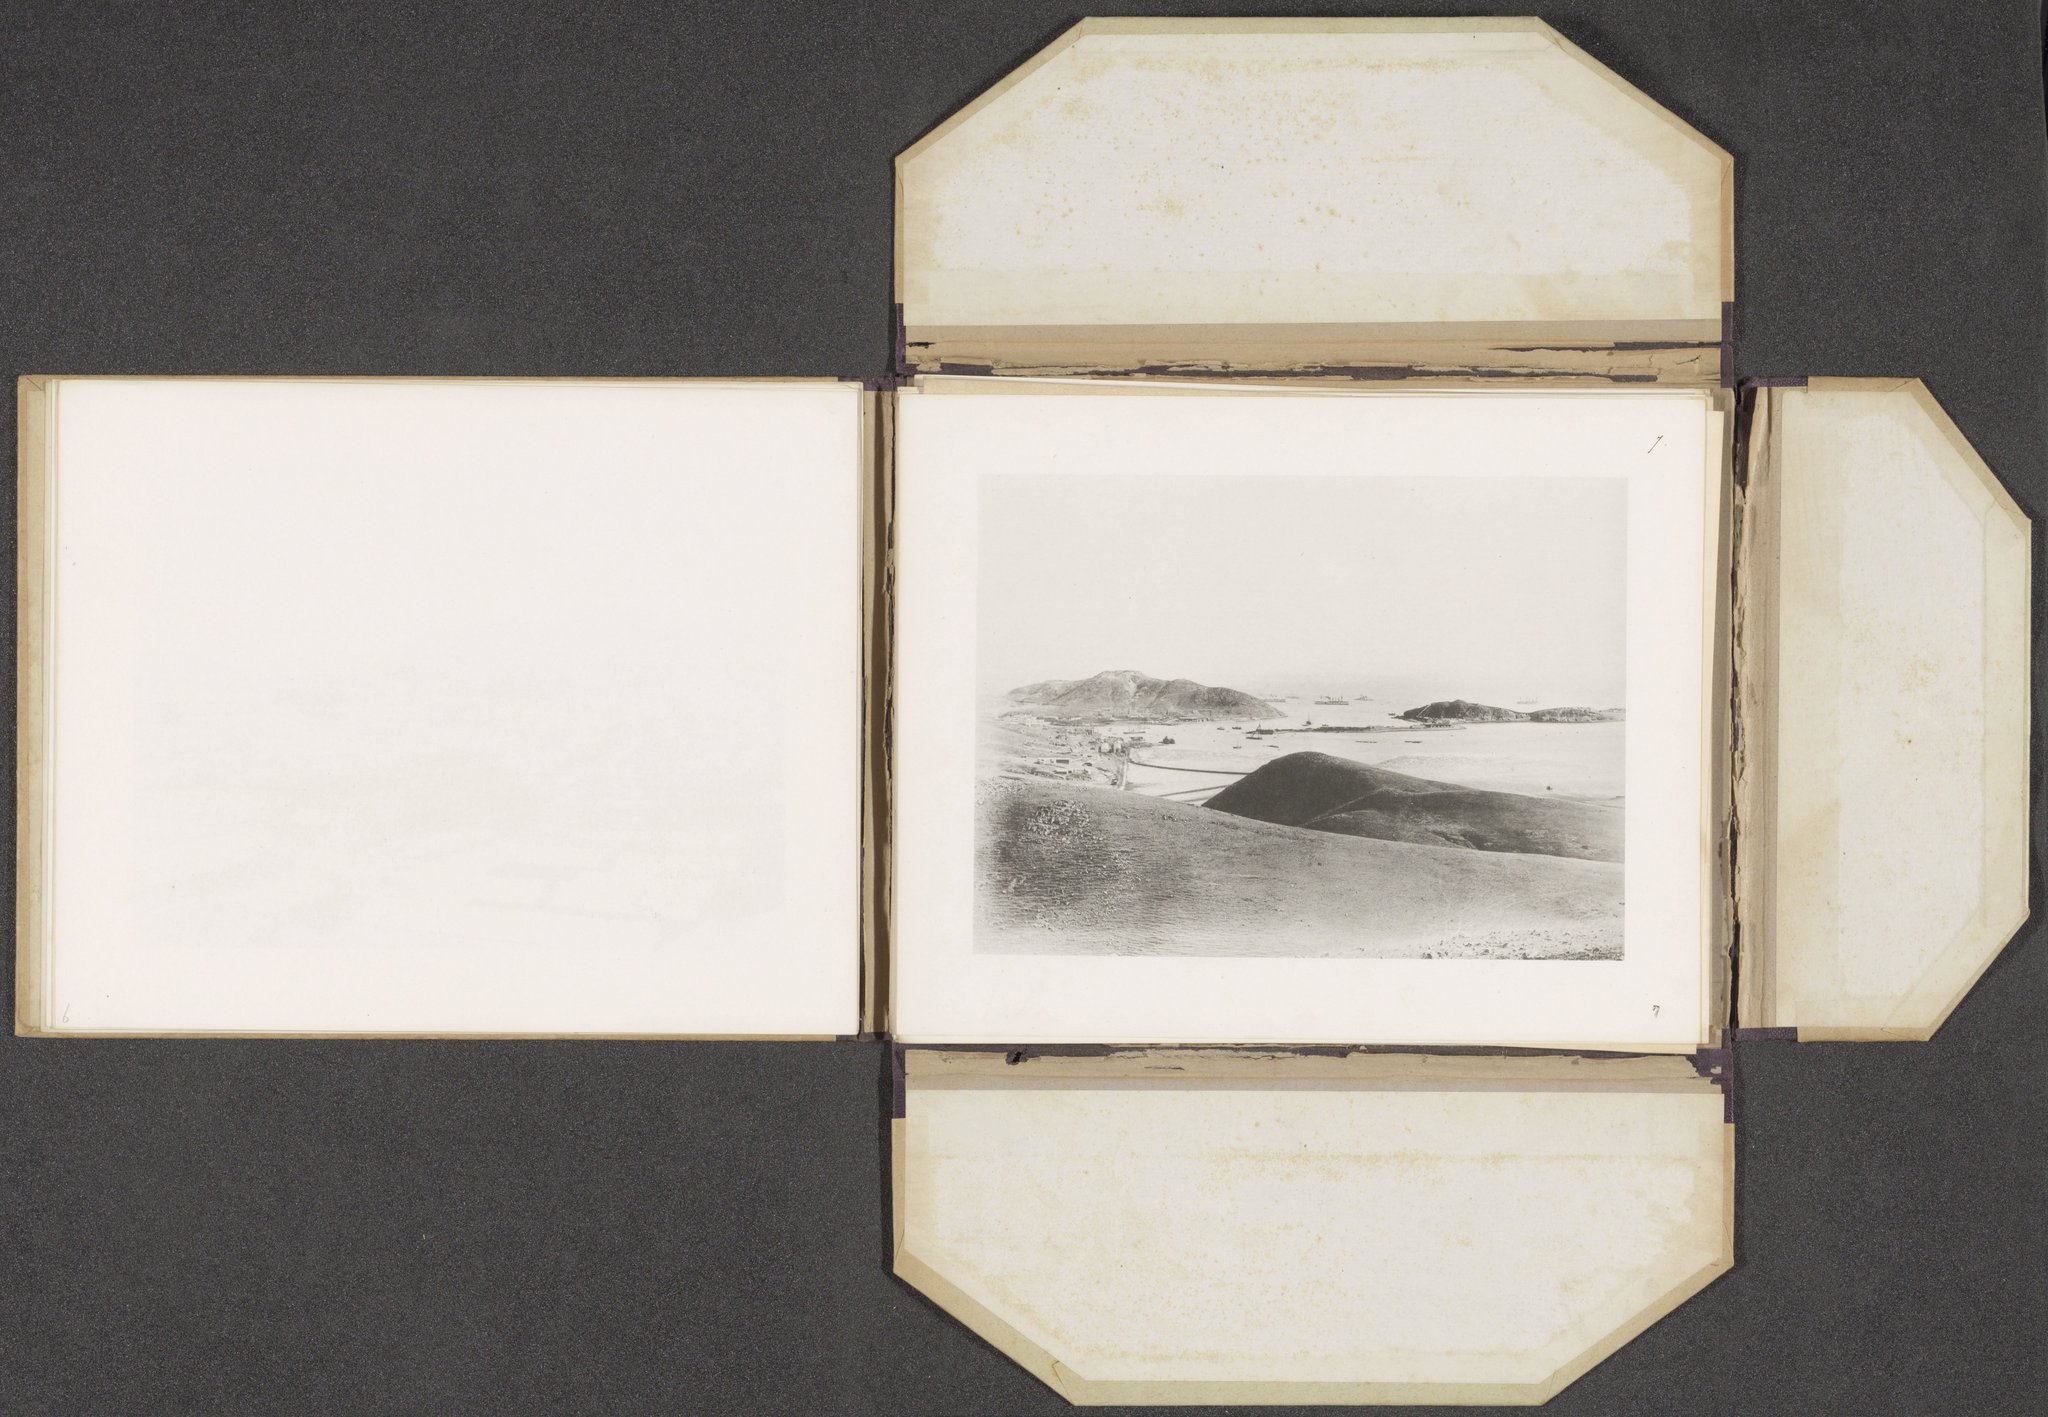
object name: page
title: Gezicht op de baai van Port Arthur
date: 1898-1899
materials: paper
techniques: photograph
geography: port arthur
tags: gulf, bay, peninsula, mountains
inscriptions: number: ‘7’, number: ‘40.-’